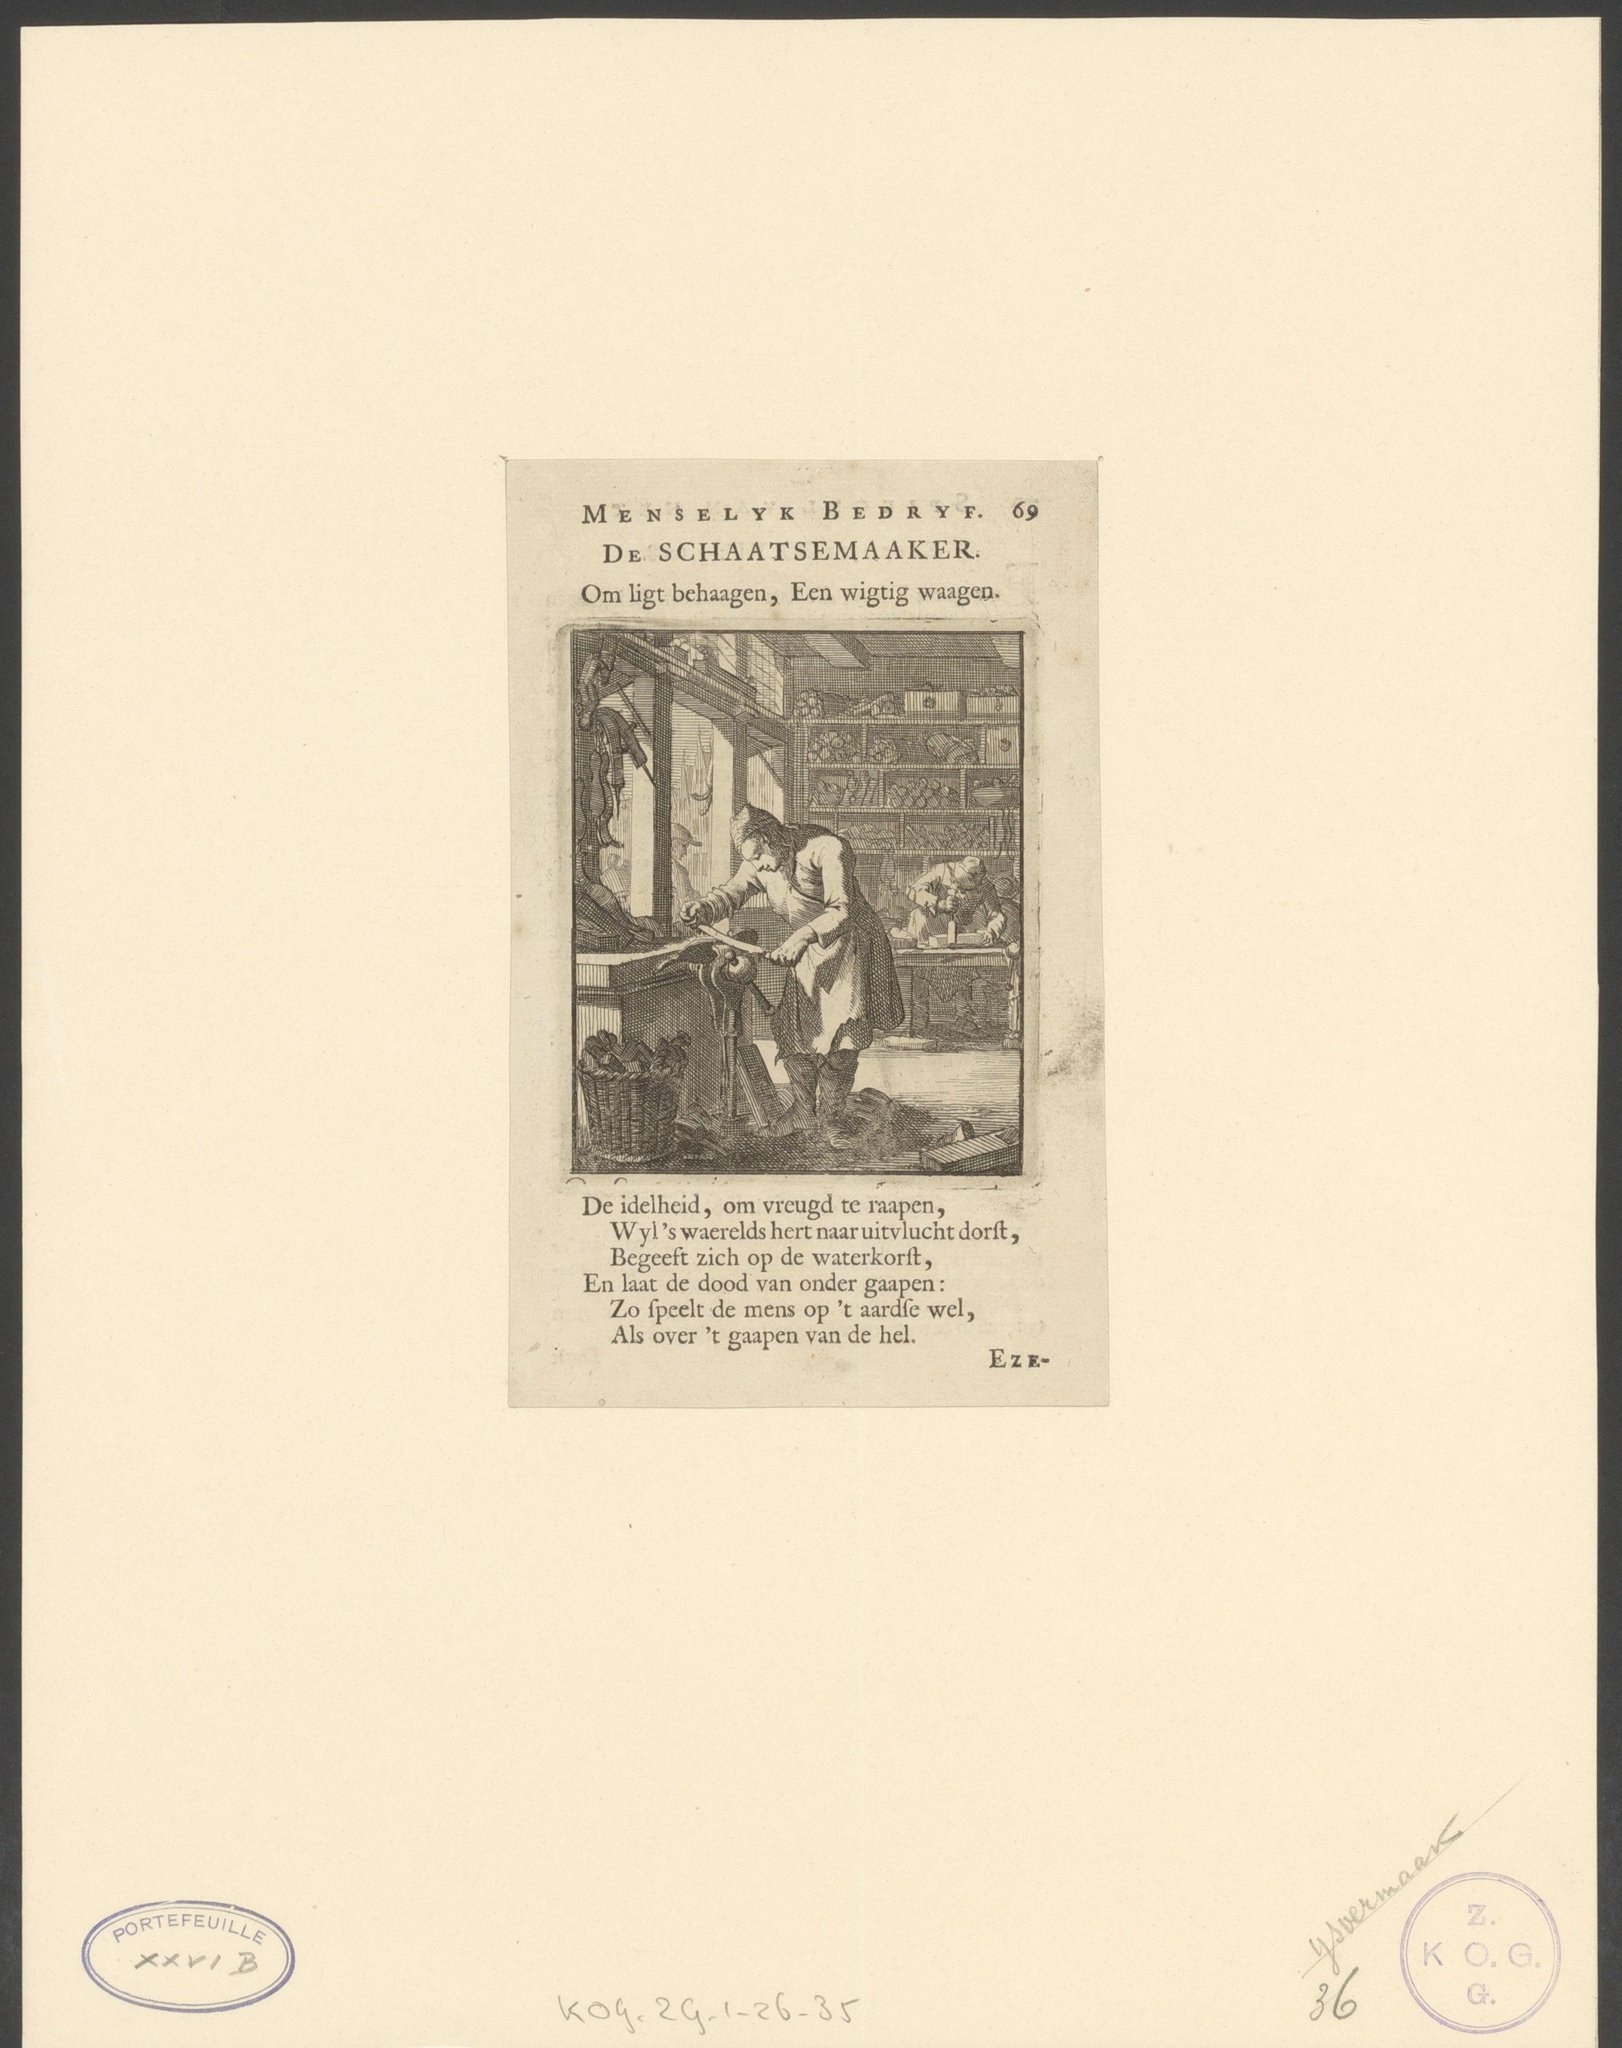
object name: book illustration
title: De Schaatsemaaker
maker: jan luyken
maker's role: draughtsman, print maker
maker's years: 1649-1712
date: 1694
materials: paper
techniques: etching, letterpress printing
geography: amsterdam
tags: craft-production, skilled handiwork (+ men (labourers)), ice ~ freezing weather, skates (winter sports), severe winters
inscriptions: collector's mark: Lugt 1641, collector's mark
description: Een schaatsenmaker bezig in zijn werkplaats met het maken of slijpen van schaatsen. Genummerd rechtsboven: 69. Ingekorte plaat. Bedrukt met tekst op achterzijde. Onderwerpsrubrieken binnen de Atlas Zeden en Gewoonten: Spel en Vermaak; IJsvermaak, Schaatsenrijden.